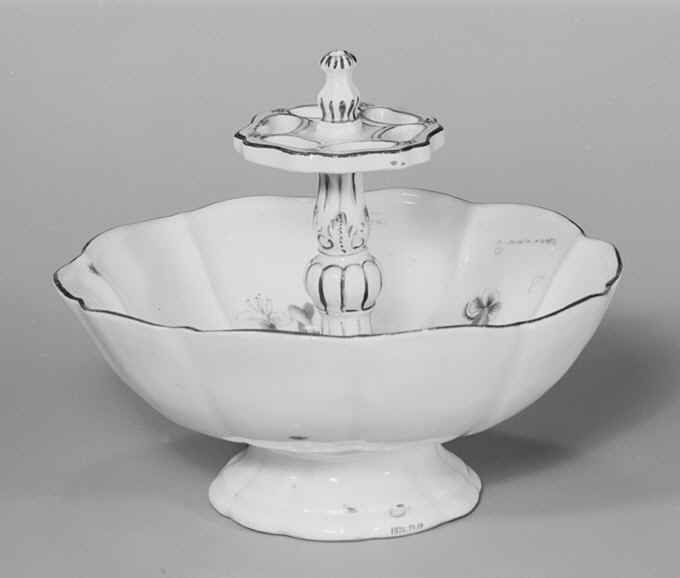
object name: spoon stand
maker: meissen manufactory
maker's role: manufactory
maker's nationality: german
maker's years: 1710-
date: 1760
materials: hard paste porcelain